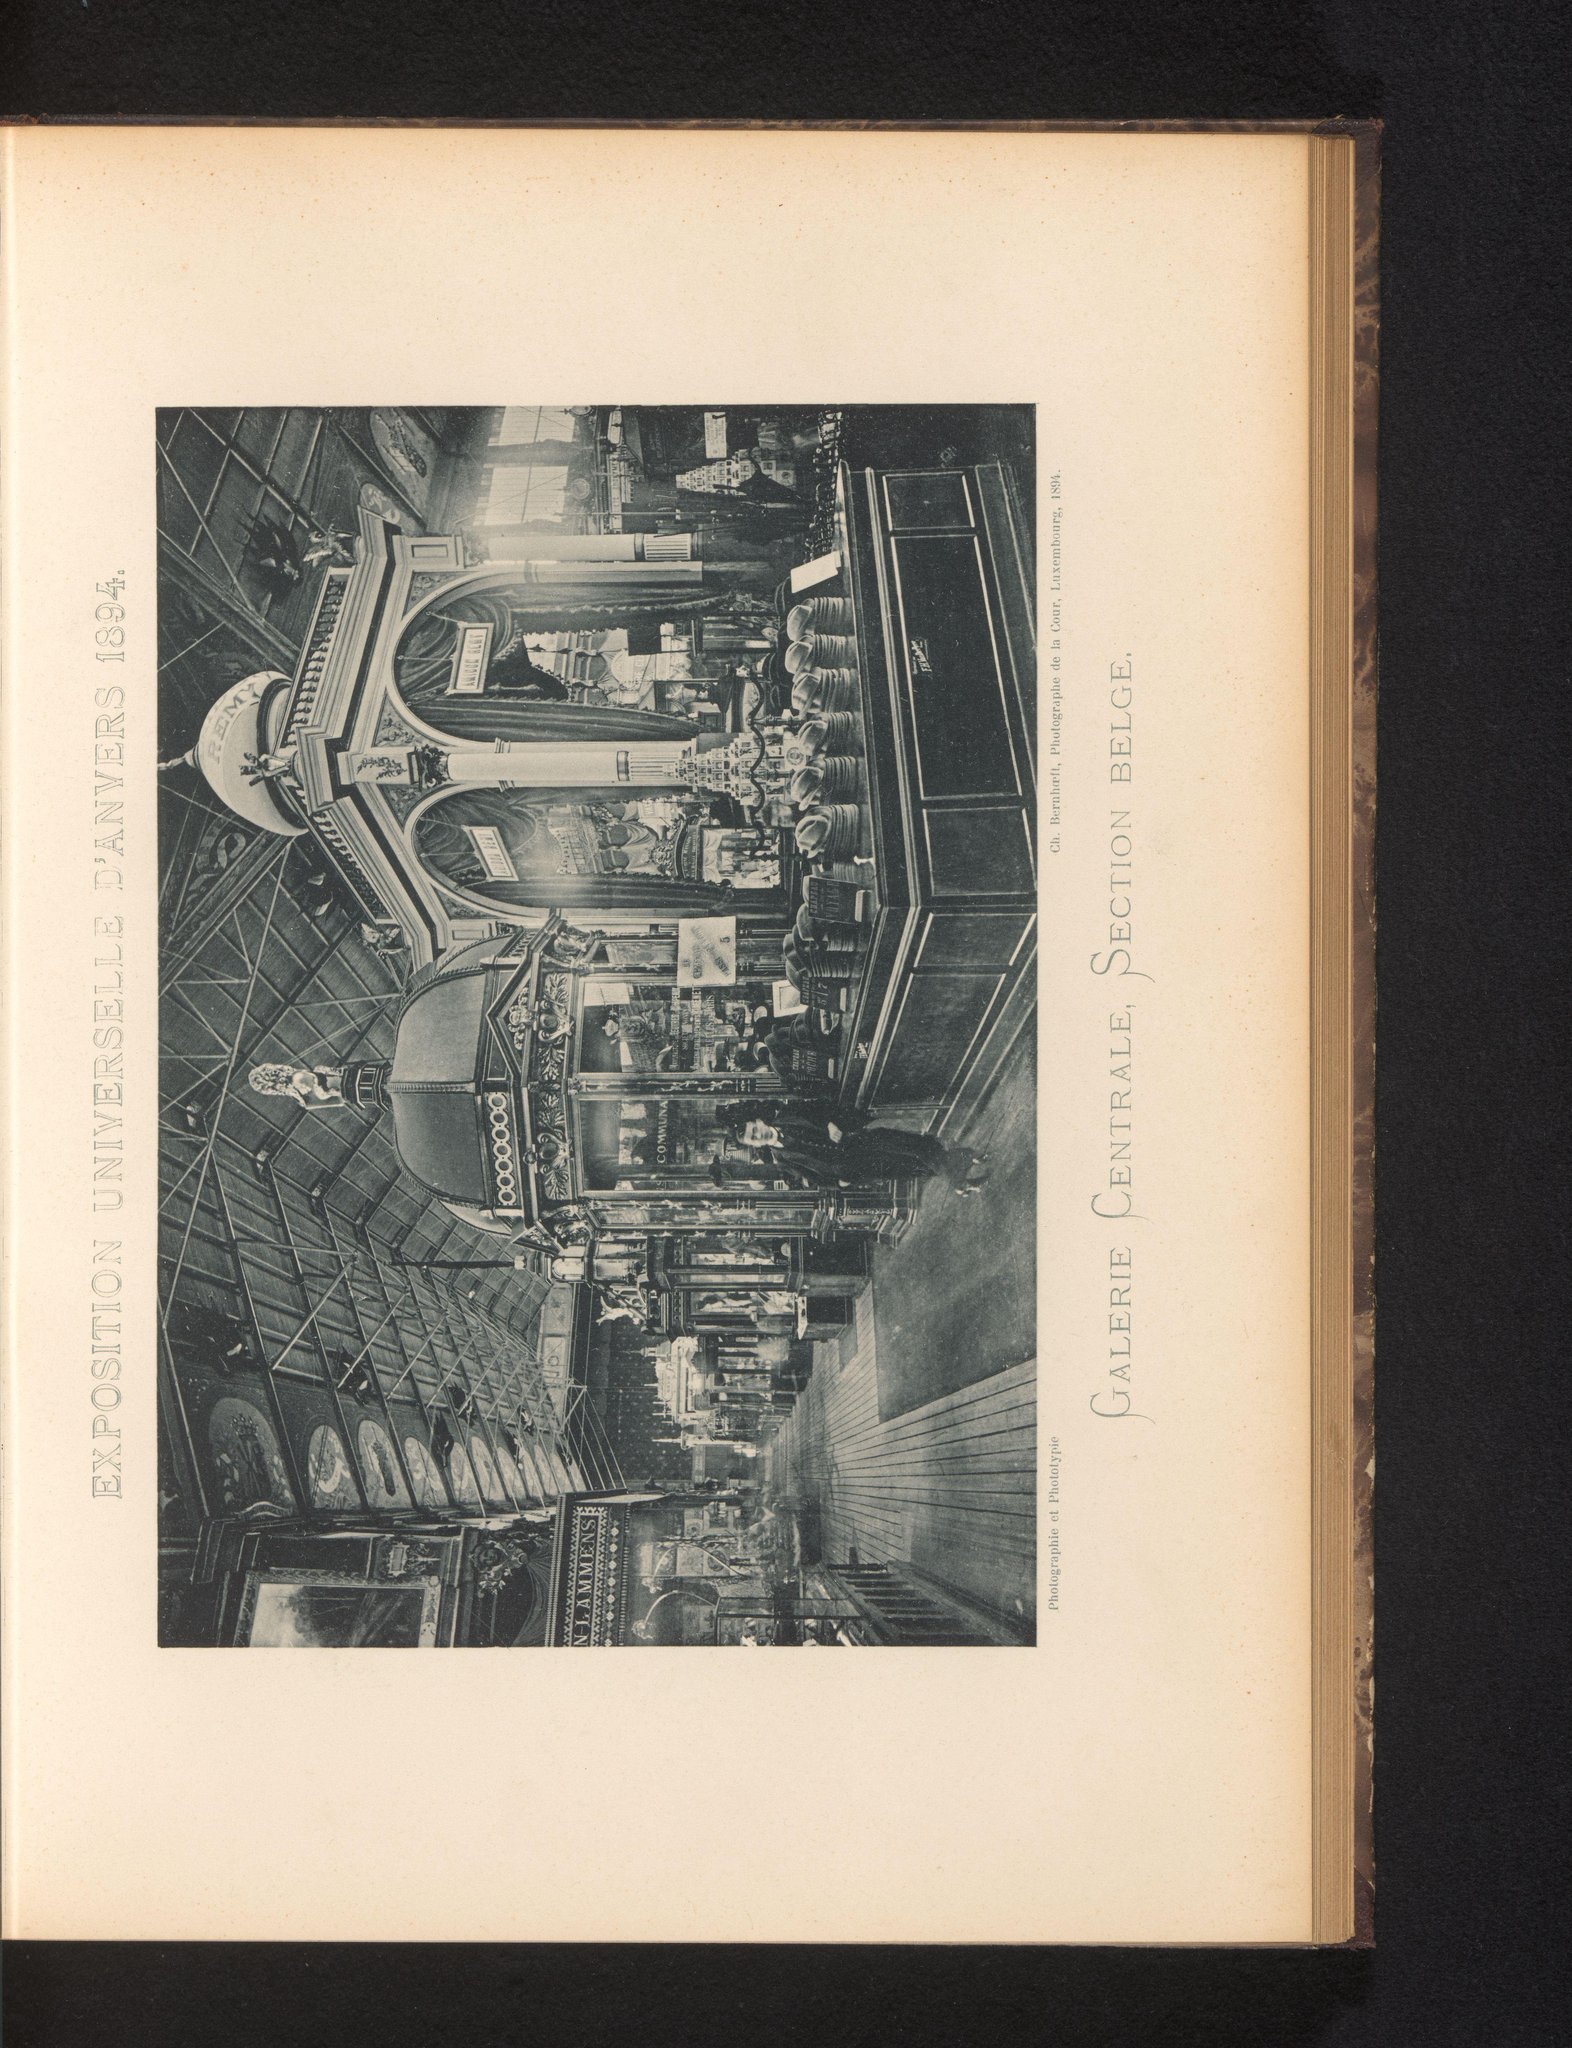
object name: photomechanical print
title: Galerie Centrale, Section belge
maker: charles bernhoeft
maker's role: publisher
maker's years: 1859-1933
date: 1894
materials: paper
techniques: photograph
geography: antwerp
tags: counter ~ shop, world fair, world exhibition, antwerp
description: Prent op derde ongenummerde pagina na pagina 22.